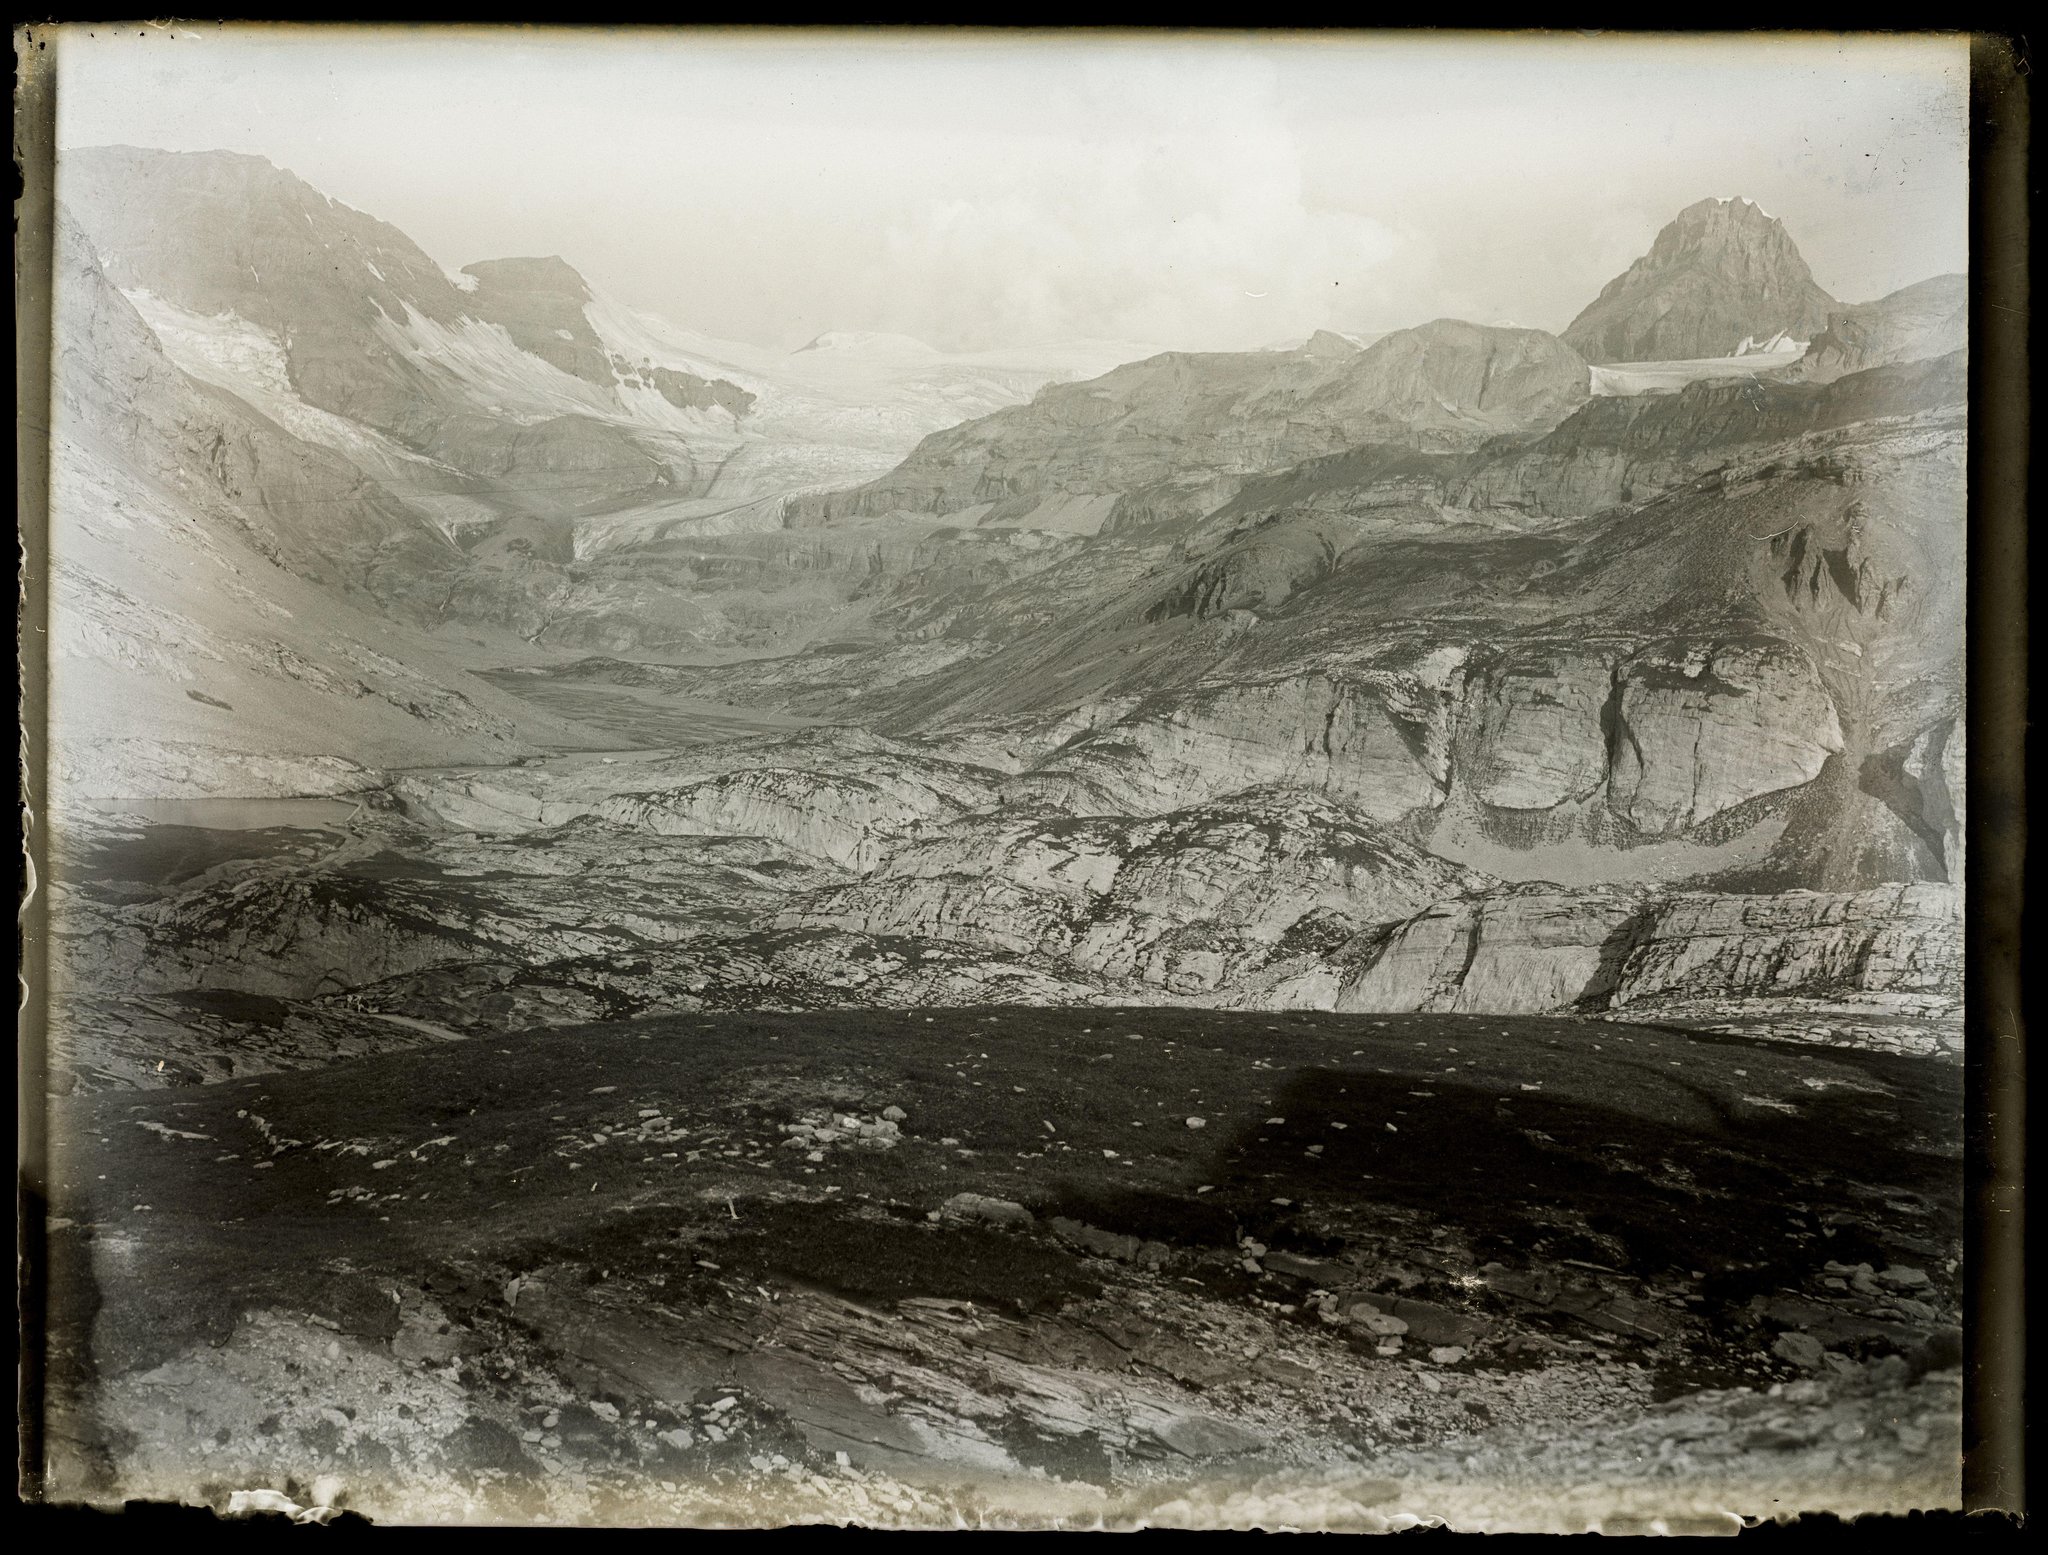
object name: glasnegatief, glasplaatnegatief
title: Berglandschap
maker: Anonymous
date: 1907-1935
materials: glass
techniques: gelatin glass negative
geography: europe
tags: mountains, europe